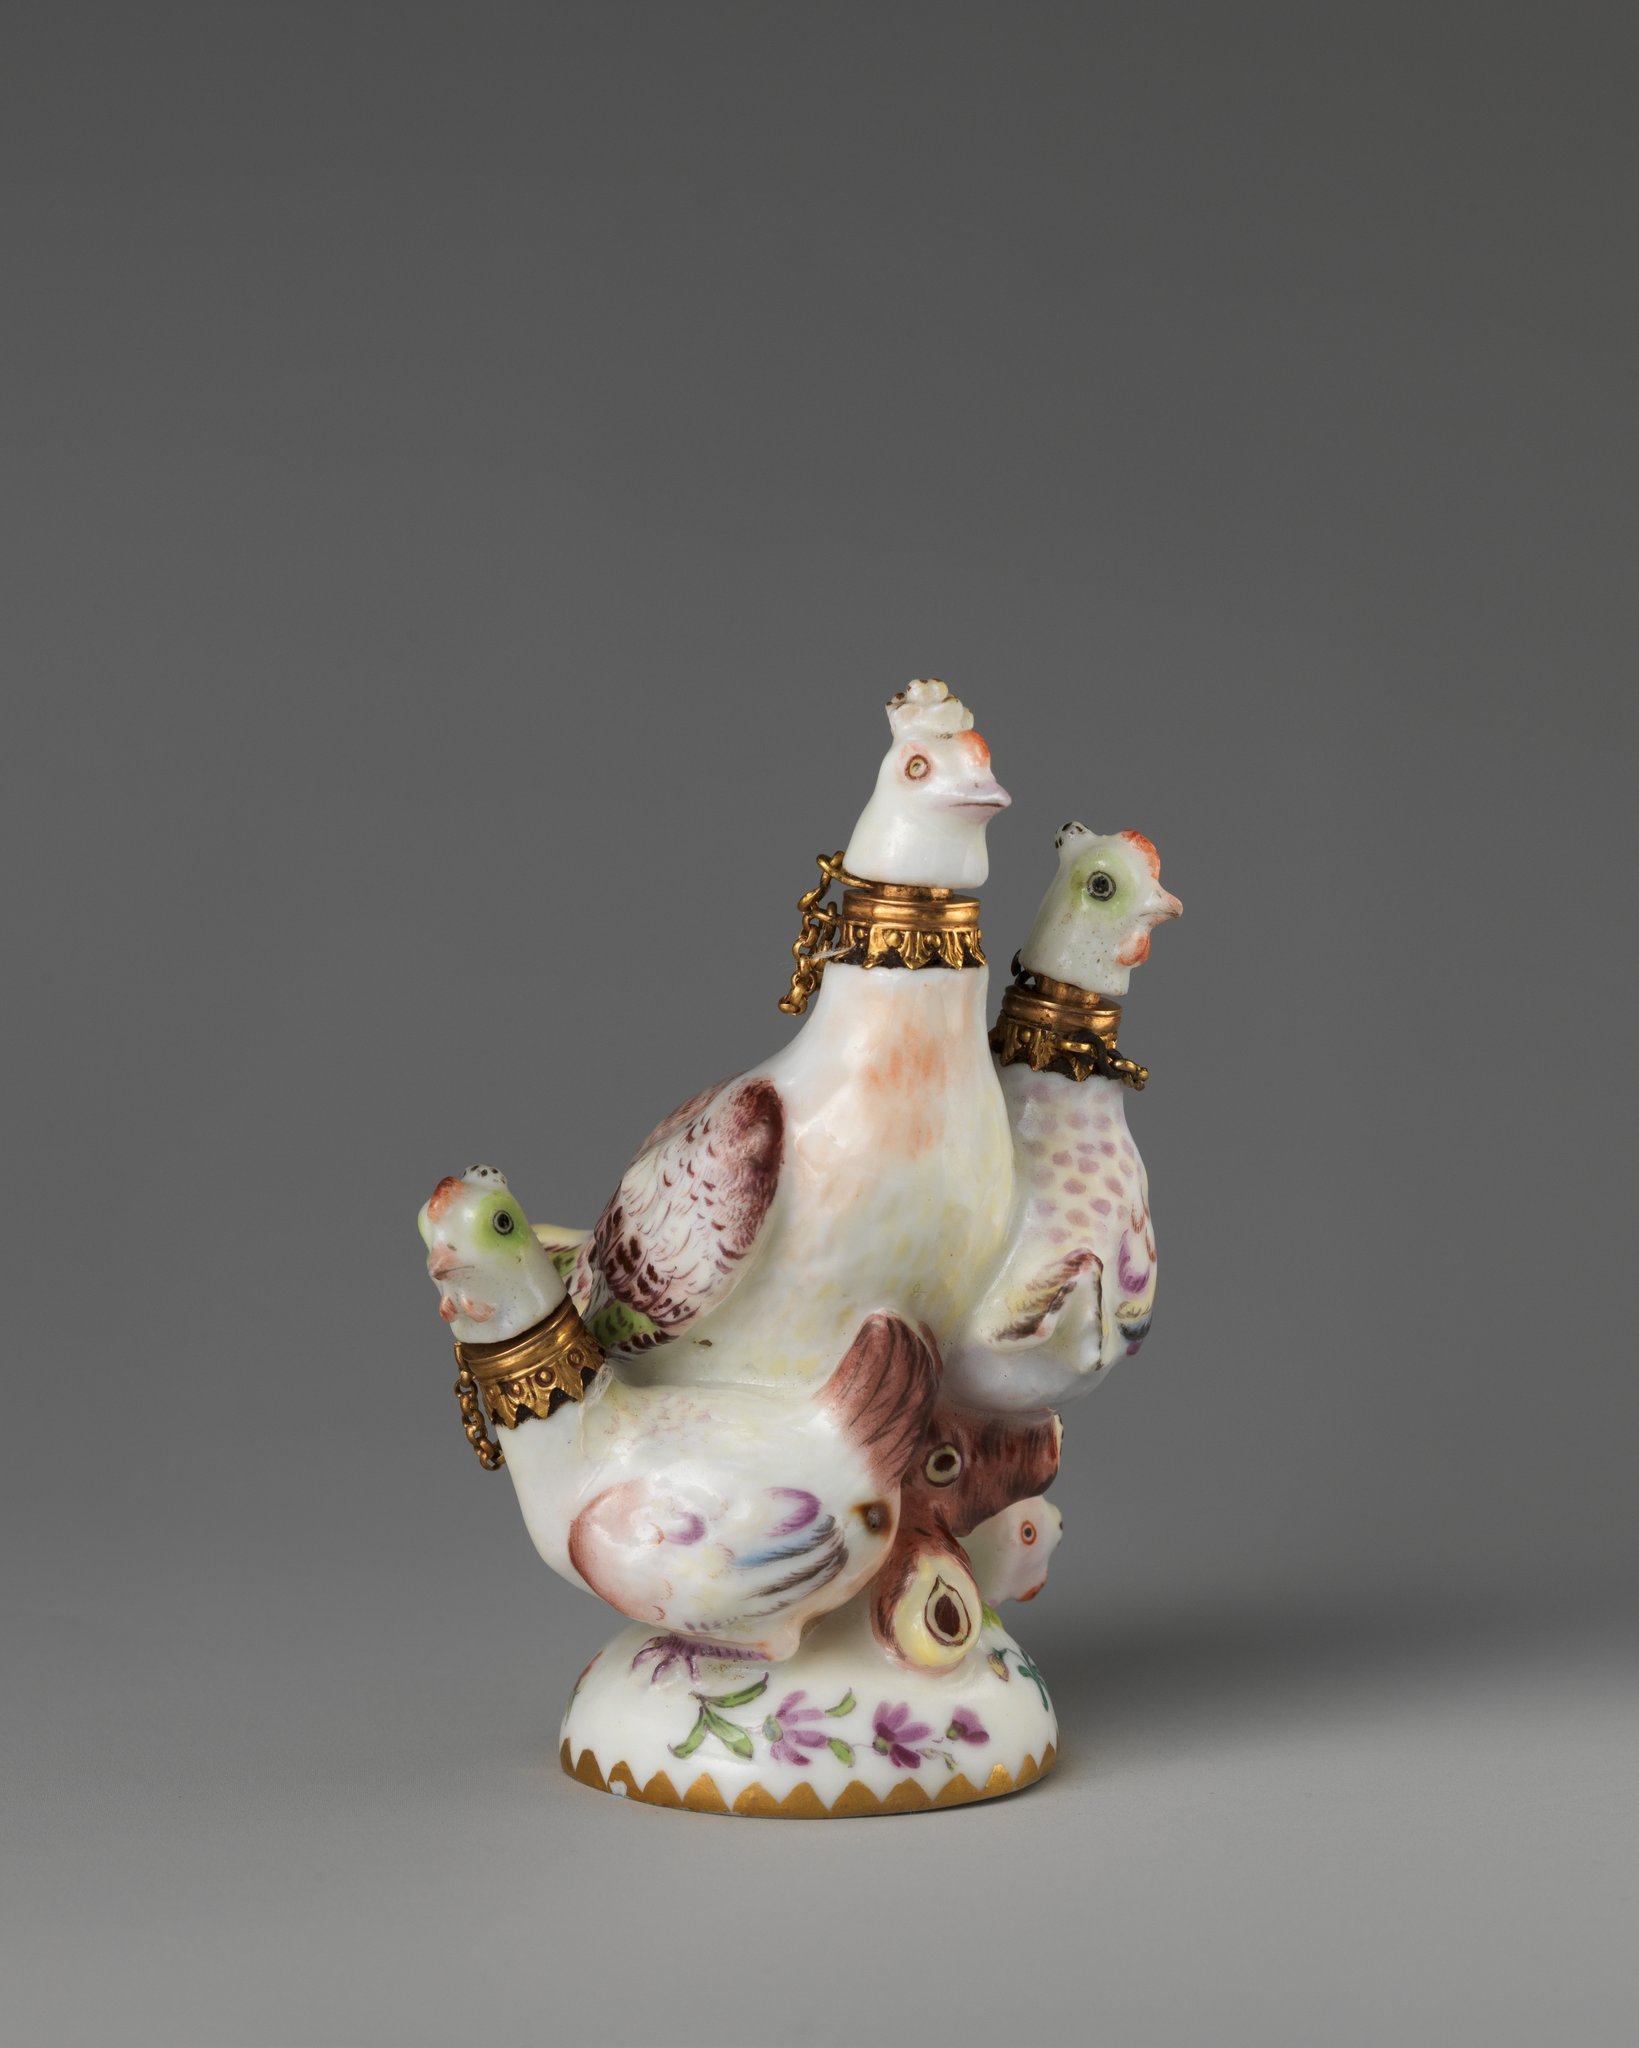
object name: toy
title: Hen and chickens in a group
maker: chelsea porcelain manufactory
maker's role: factory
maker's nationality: british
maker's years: 1744-1784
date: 1755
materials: soft paste porcelain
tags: chickens